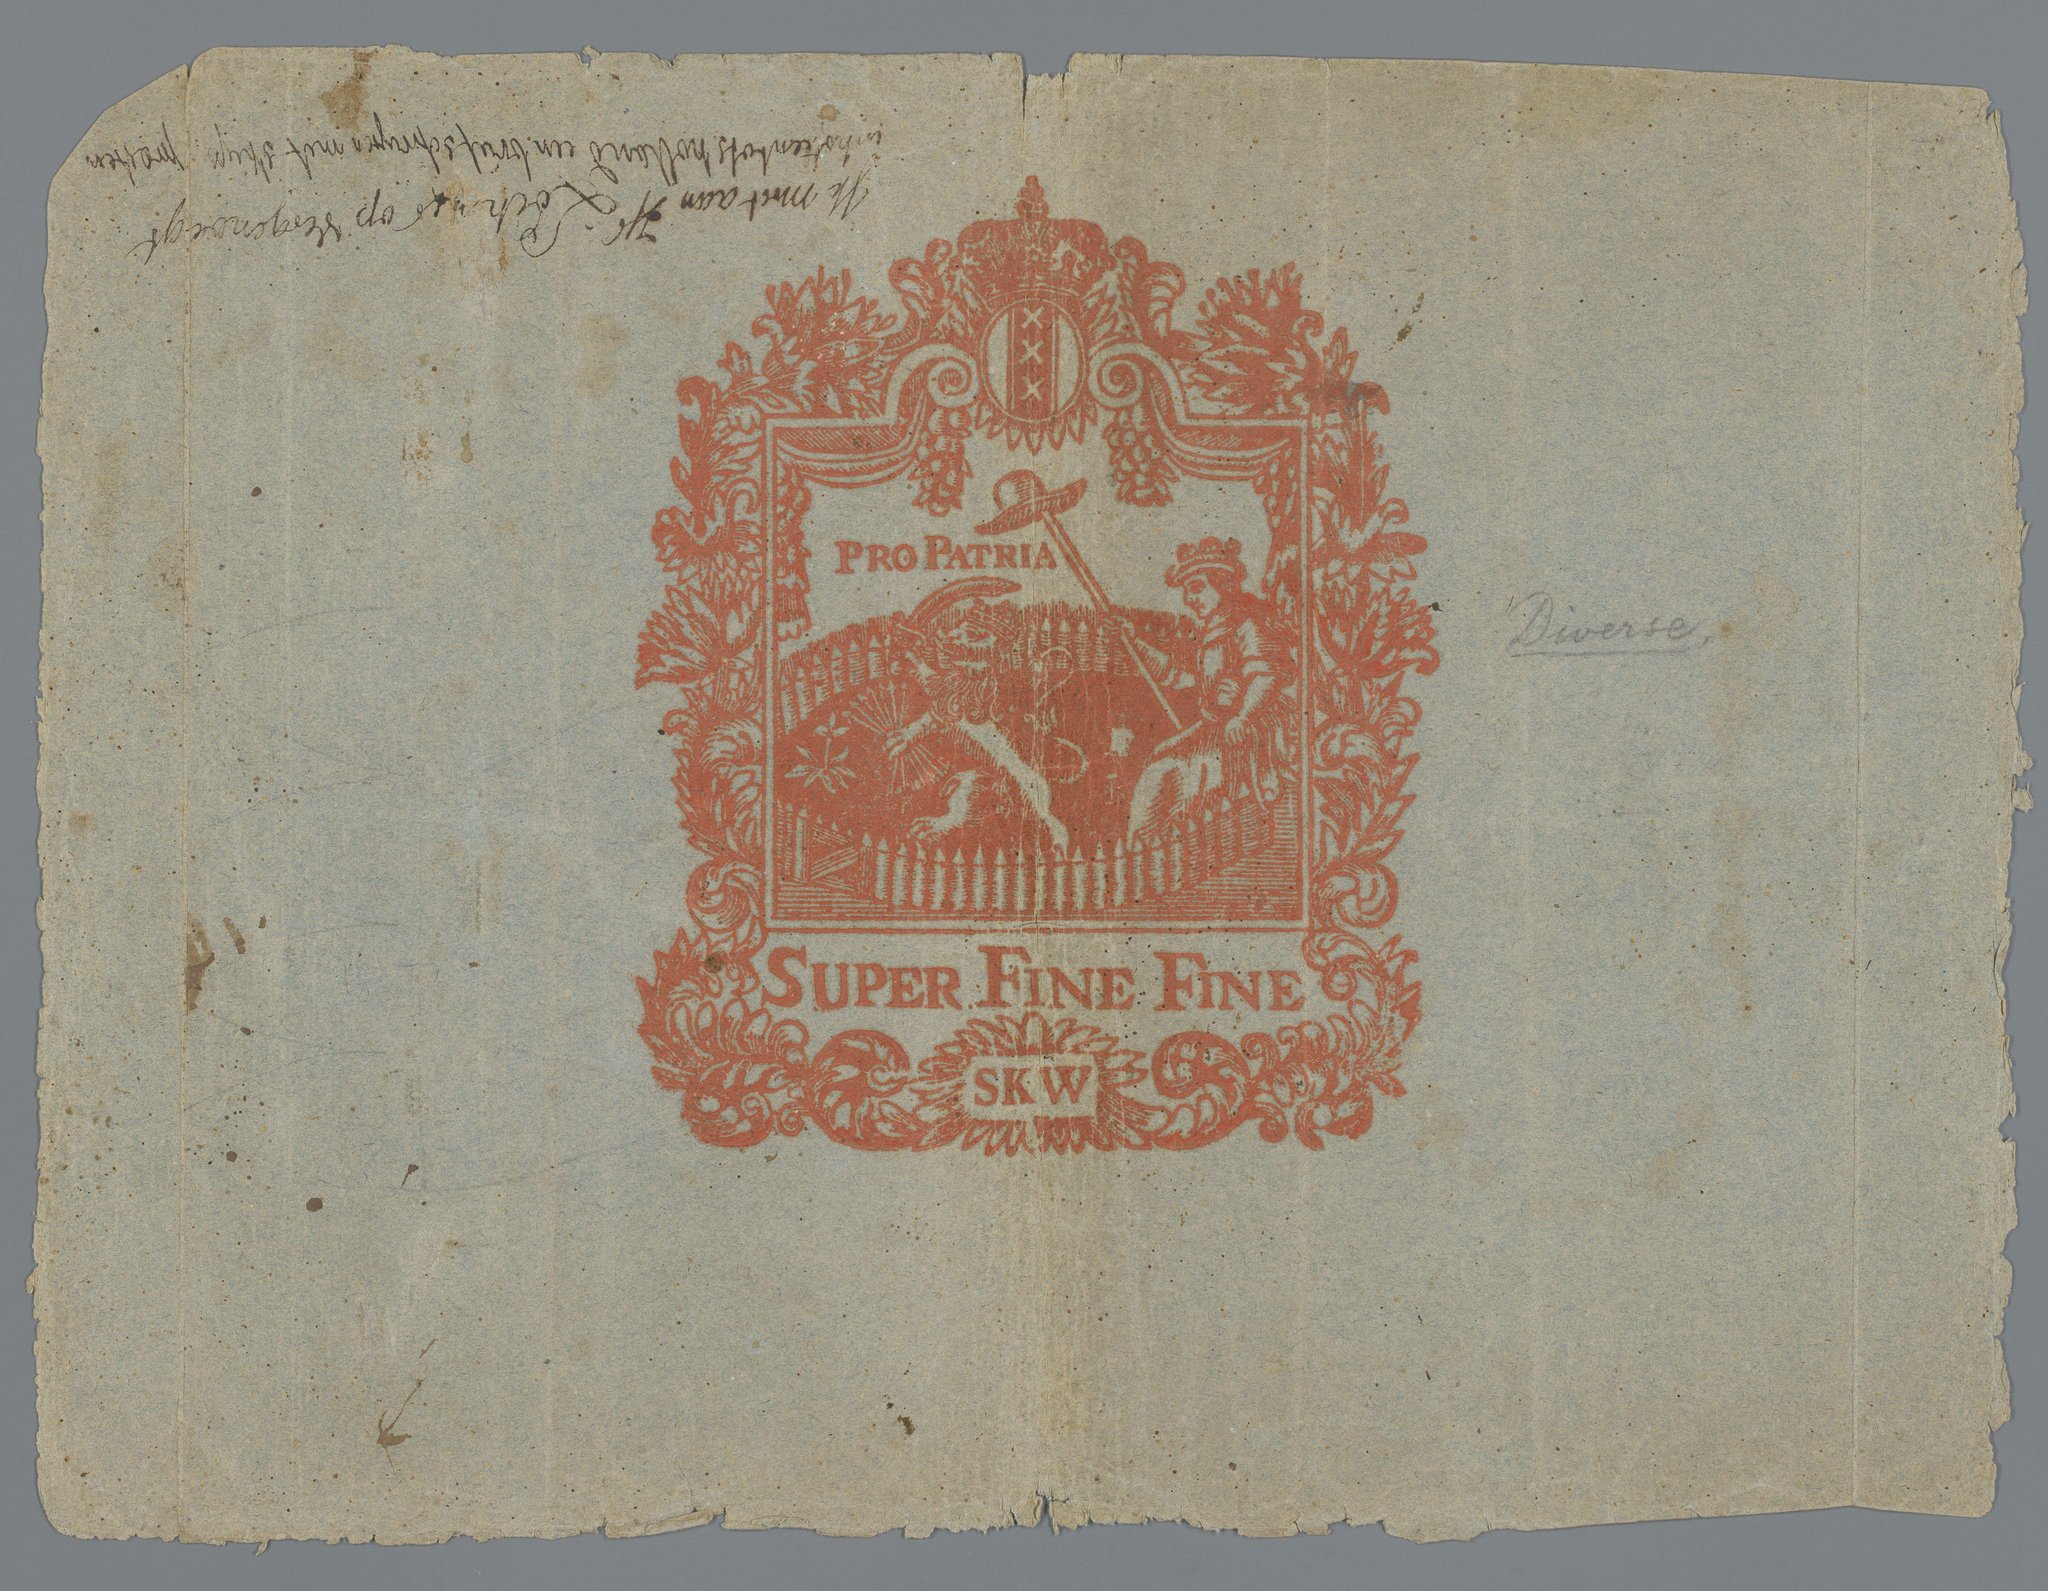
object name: riemkap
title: Riemkap in papieren Jan Brandes (1743-1808)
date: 1750-1800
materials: paper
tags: draughtsman, jan brandes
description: Blauwe riemkap (omslag van een riem papier) met rood gestempeld merk 'Pro Patria Fine'. Opschrift 'Diverse' is van 20ste eeuwer Kellberg. Ook opschrift; 'ik moet aan Hr Lochner op vergenoegt iin hottentots holland een brief schrijven met sthijn praten'.